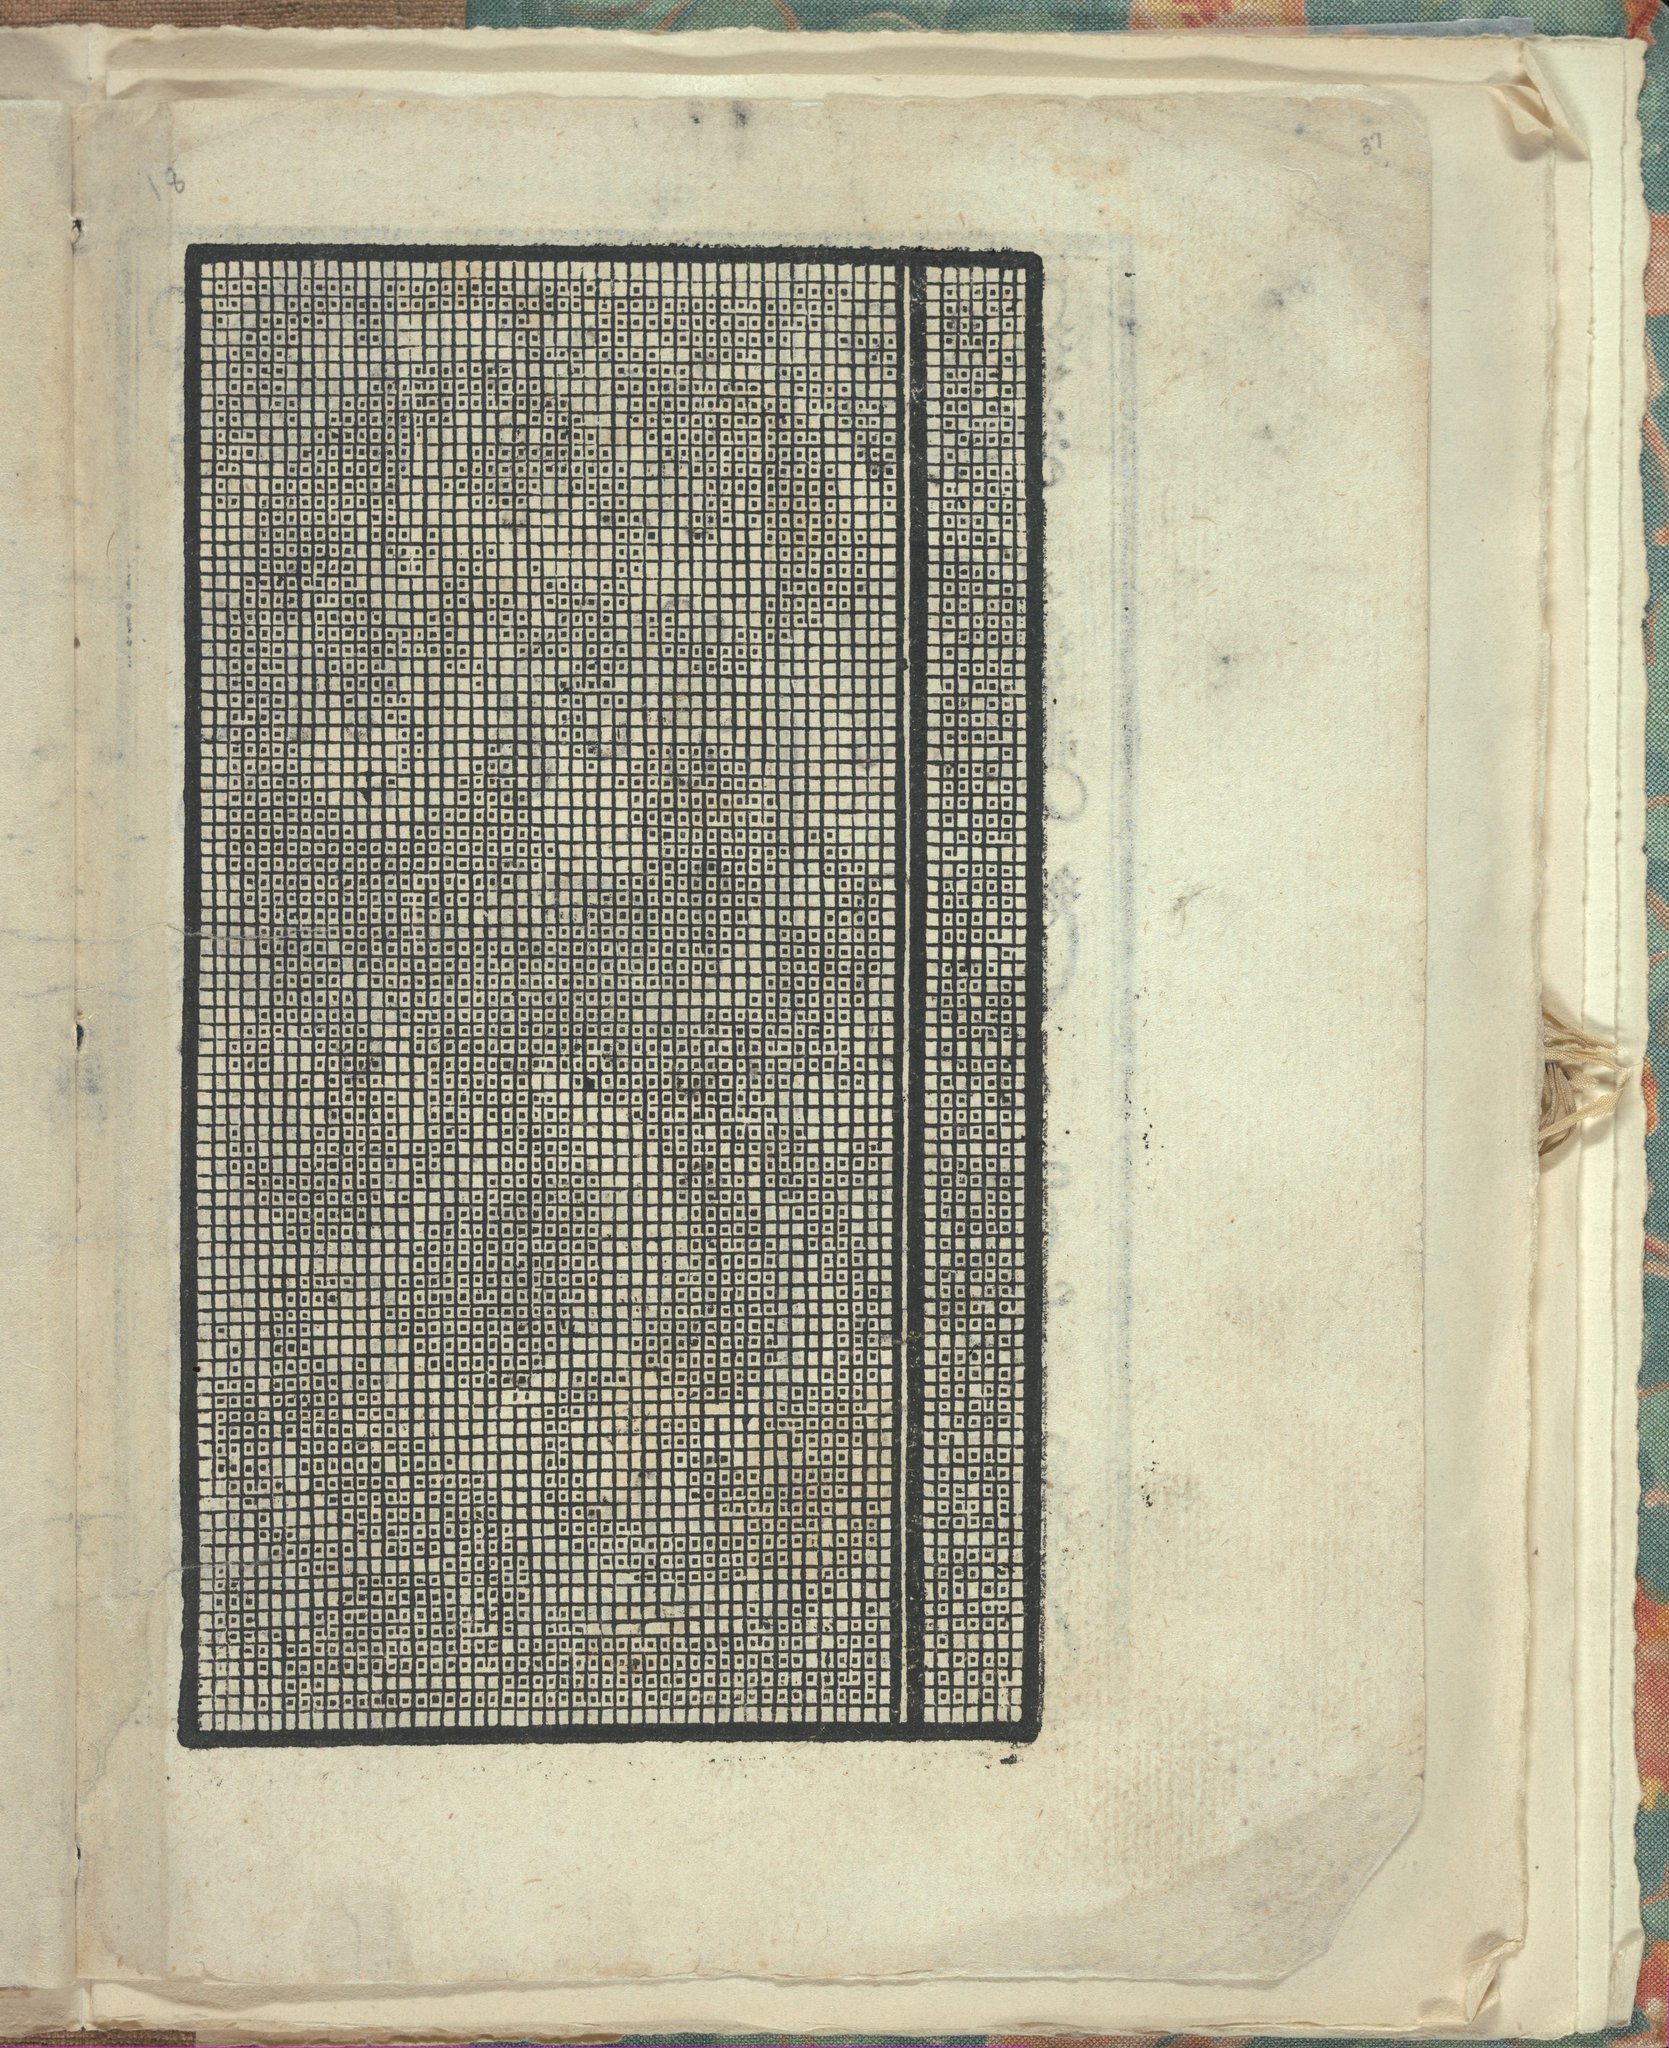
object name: book print ornament architecture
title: Opera Nova Universali intitulata Corona di racammi, page 37 (recto)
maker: giovanni andrea vavassore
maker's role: publisher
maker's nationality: italian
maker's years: 1530-1573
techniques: woodcut